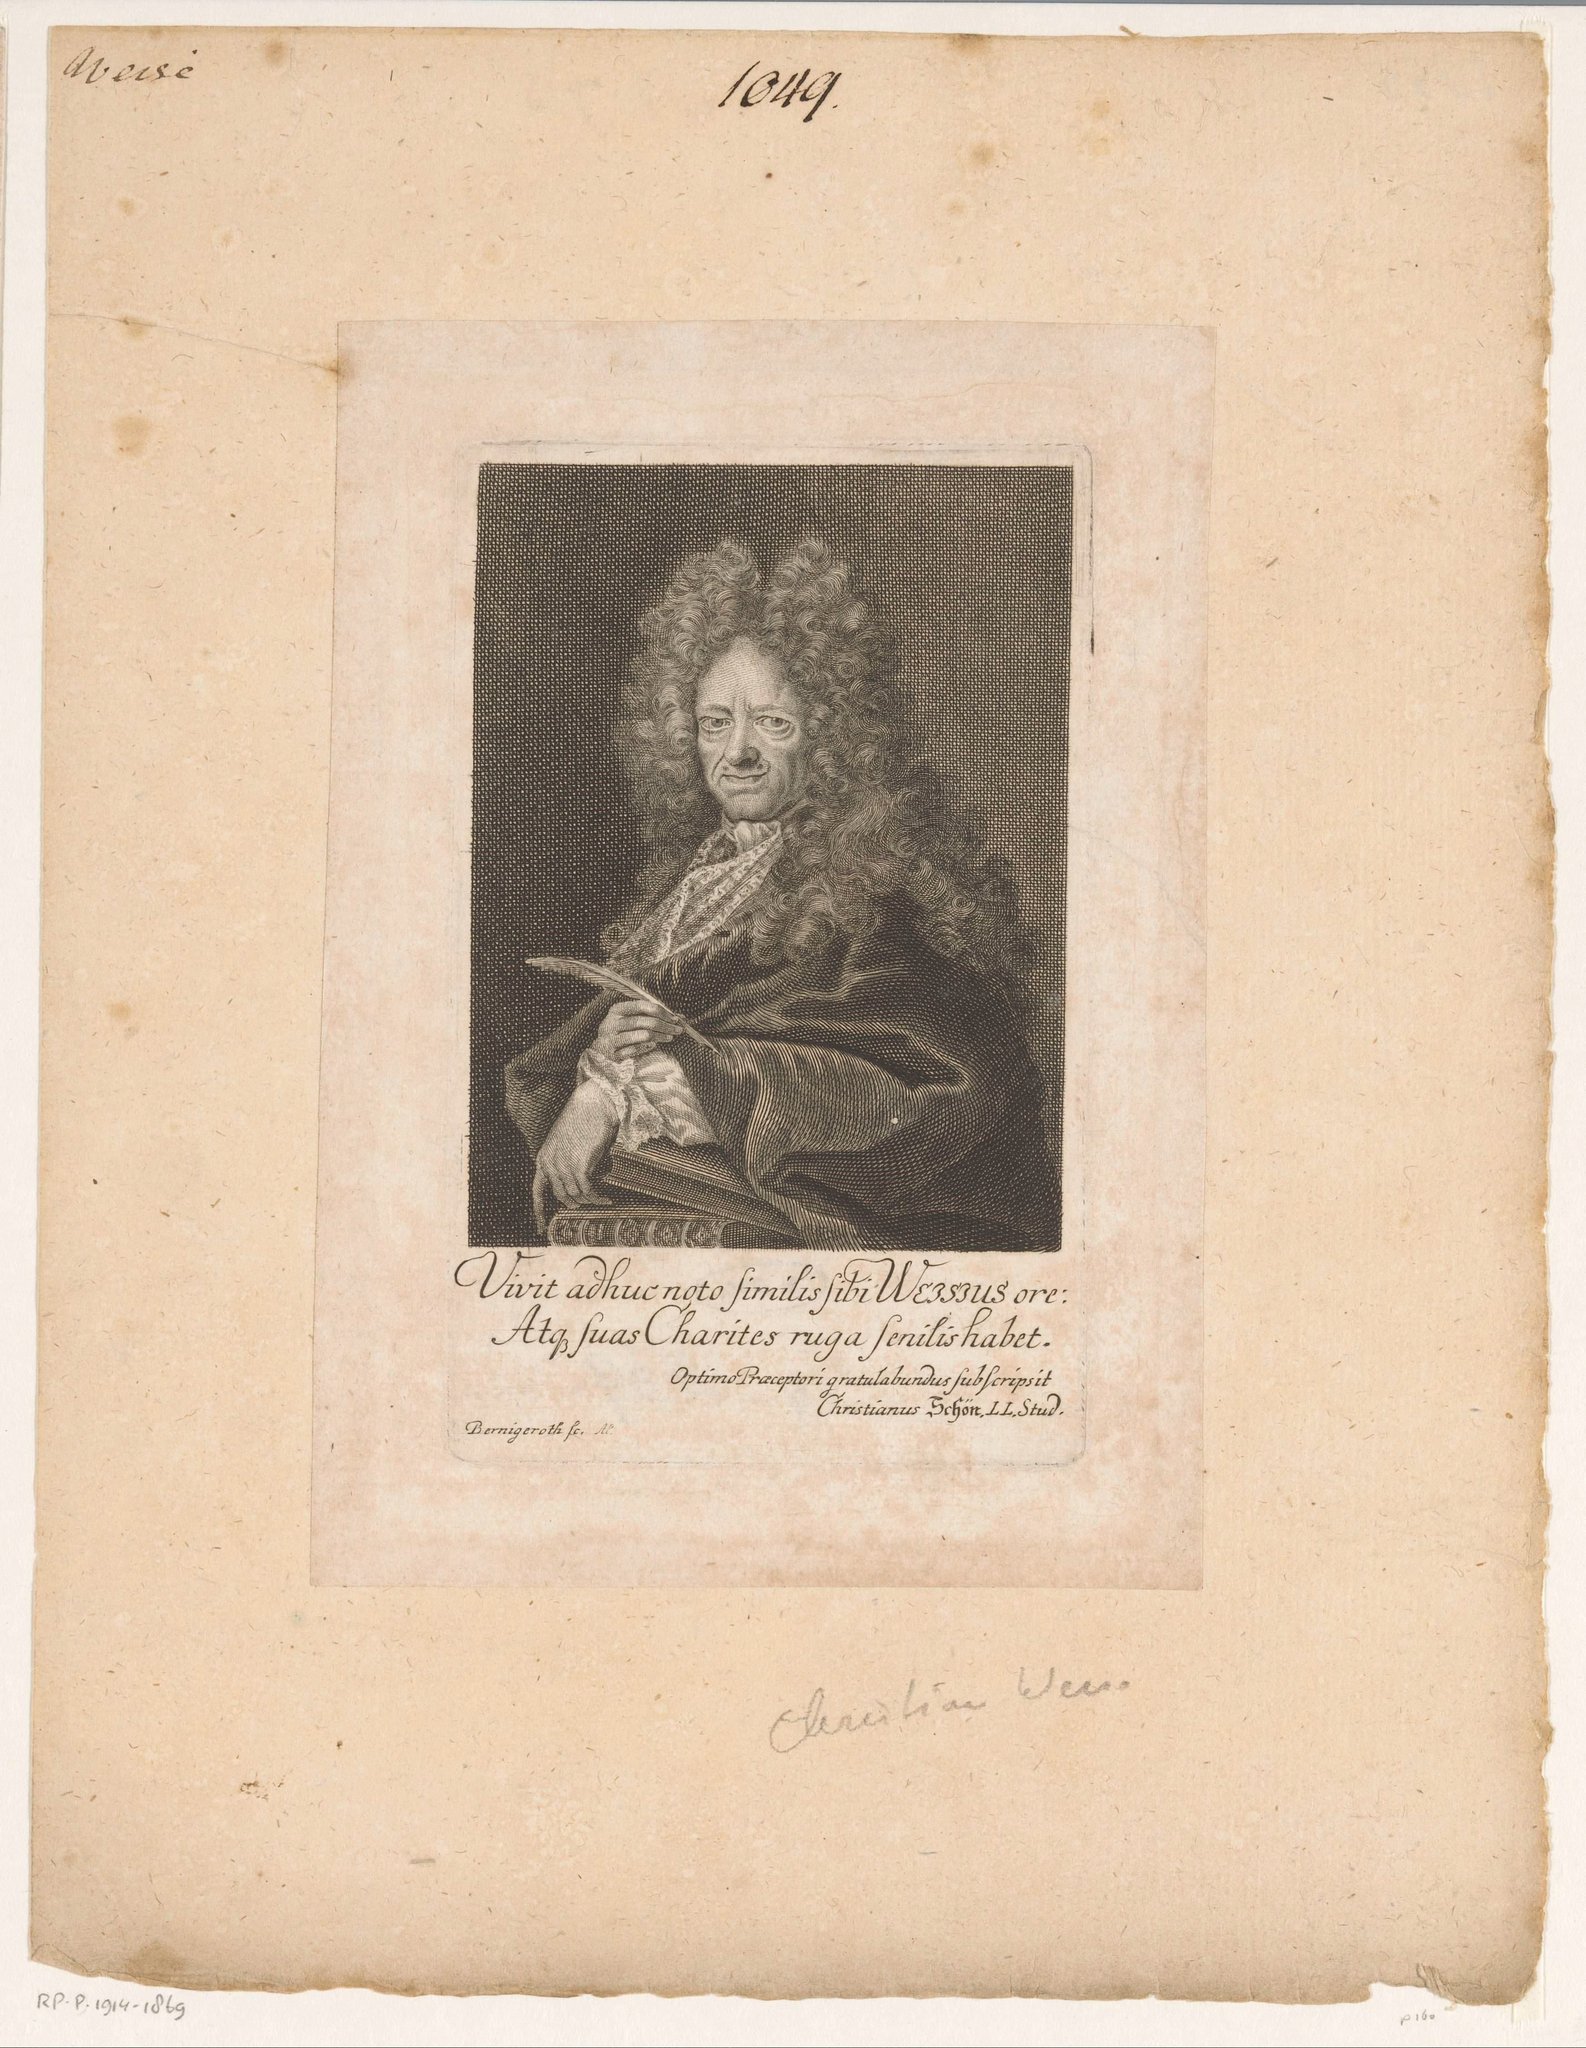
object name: print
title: Portret van Christian Weise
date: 1690-1733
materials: paper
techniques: engraving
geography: leipzig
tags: quill, historical persons, book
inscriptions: collector's mark: Lugt 2228